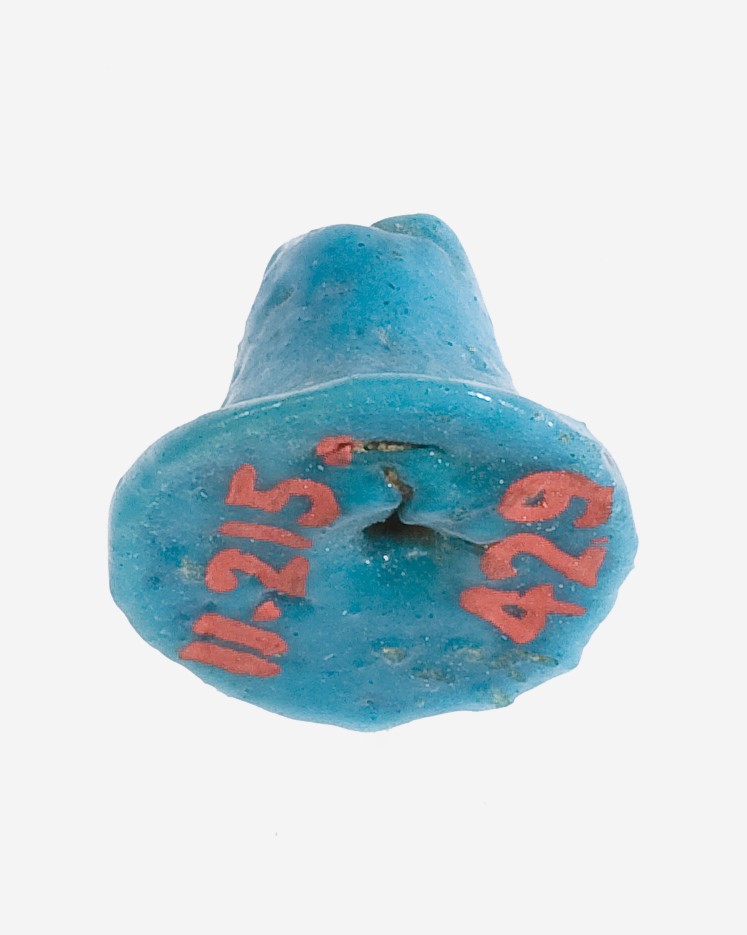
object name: pendant, umbel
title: Umbel Pendant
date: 1390-1352 BCE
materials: faience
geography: egypt